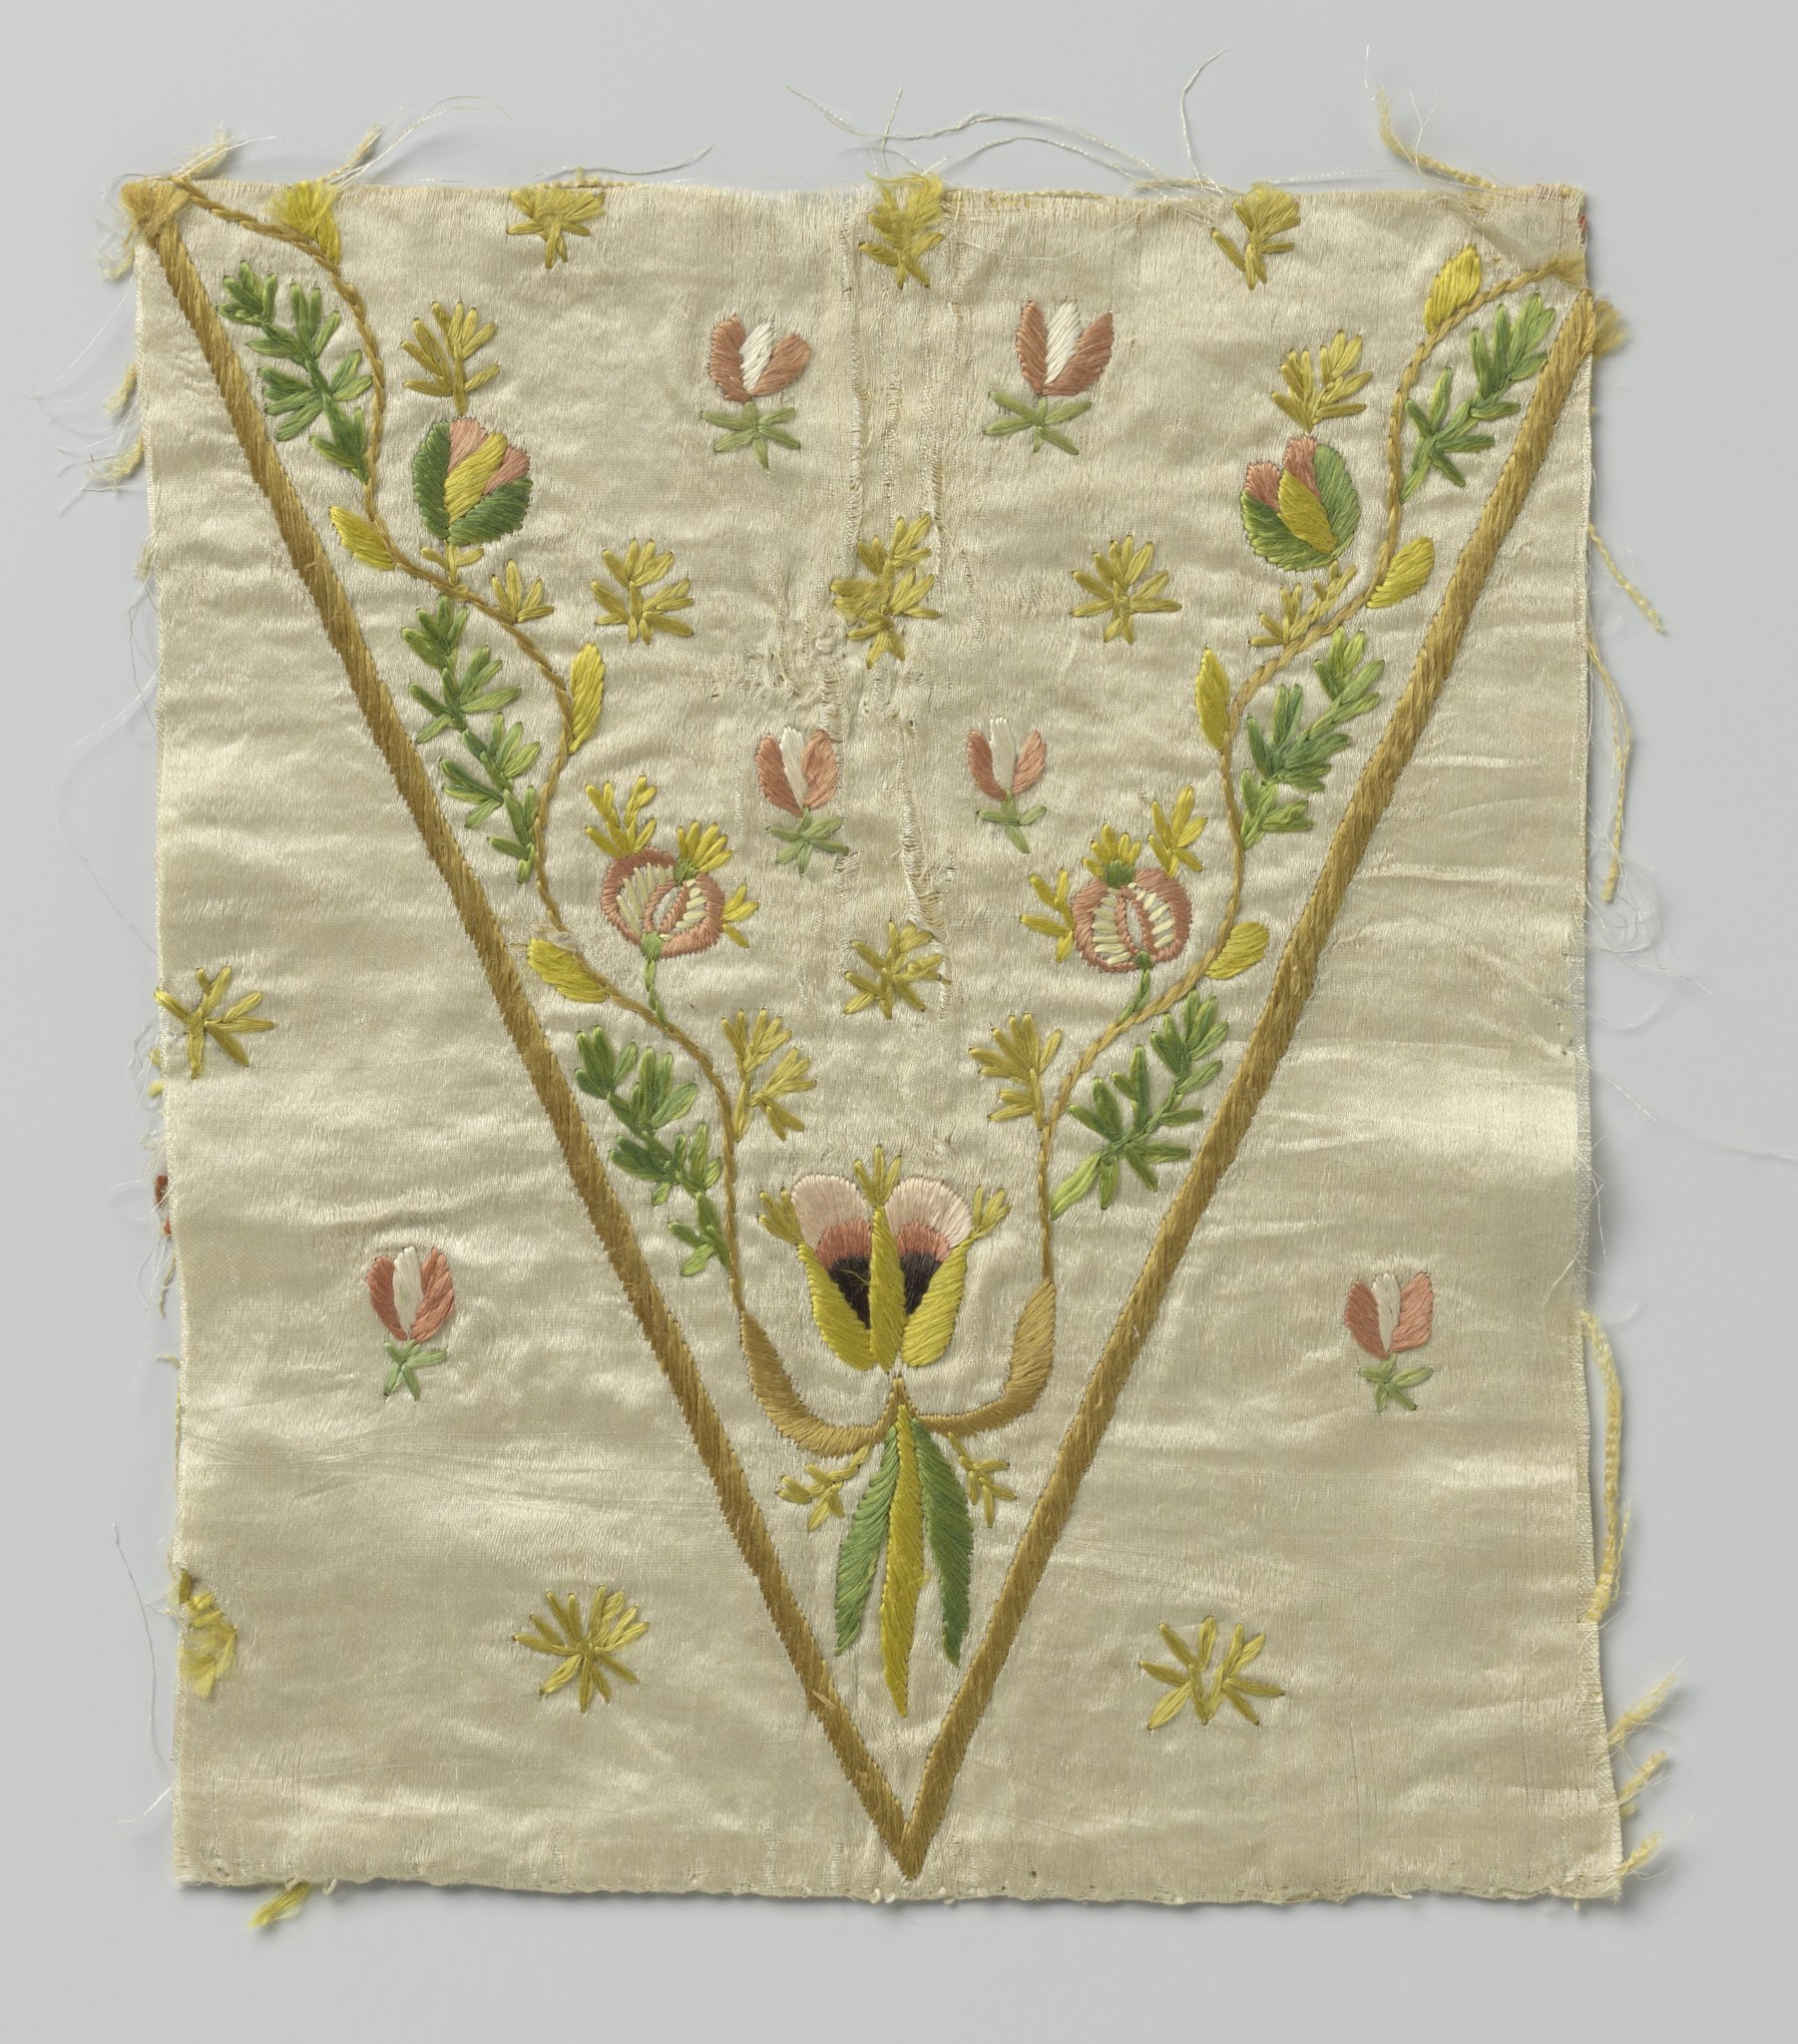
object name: zijdesatijn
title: Fragment zijdeweefsel met veelkleurig borduurwerk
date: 1680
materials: linen, textile, silk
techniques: embroidered, weave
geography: netherlands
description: Fragment wit zijdeweefsel met veelkleurig borduurwerk. Op het rechthoekige fragment is een V-vorm geborduurd die is gevuld met gestrooide bloemen en bladeren en langs de benen van de V een bloemenrank. Buiten de V-vorm heeft het patroon eveneens gestrooide bloemen en bladeren.